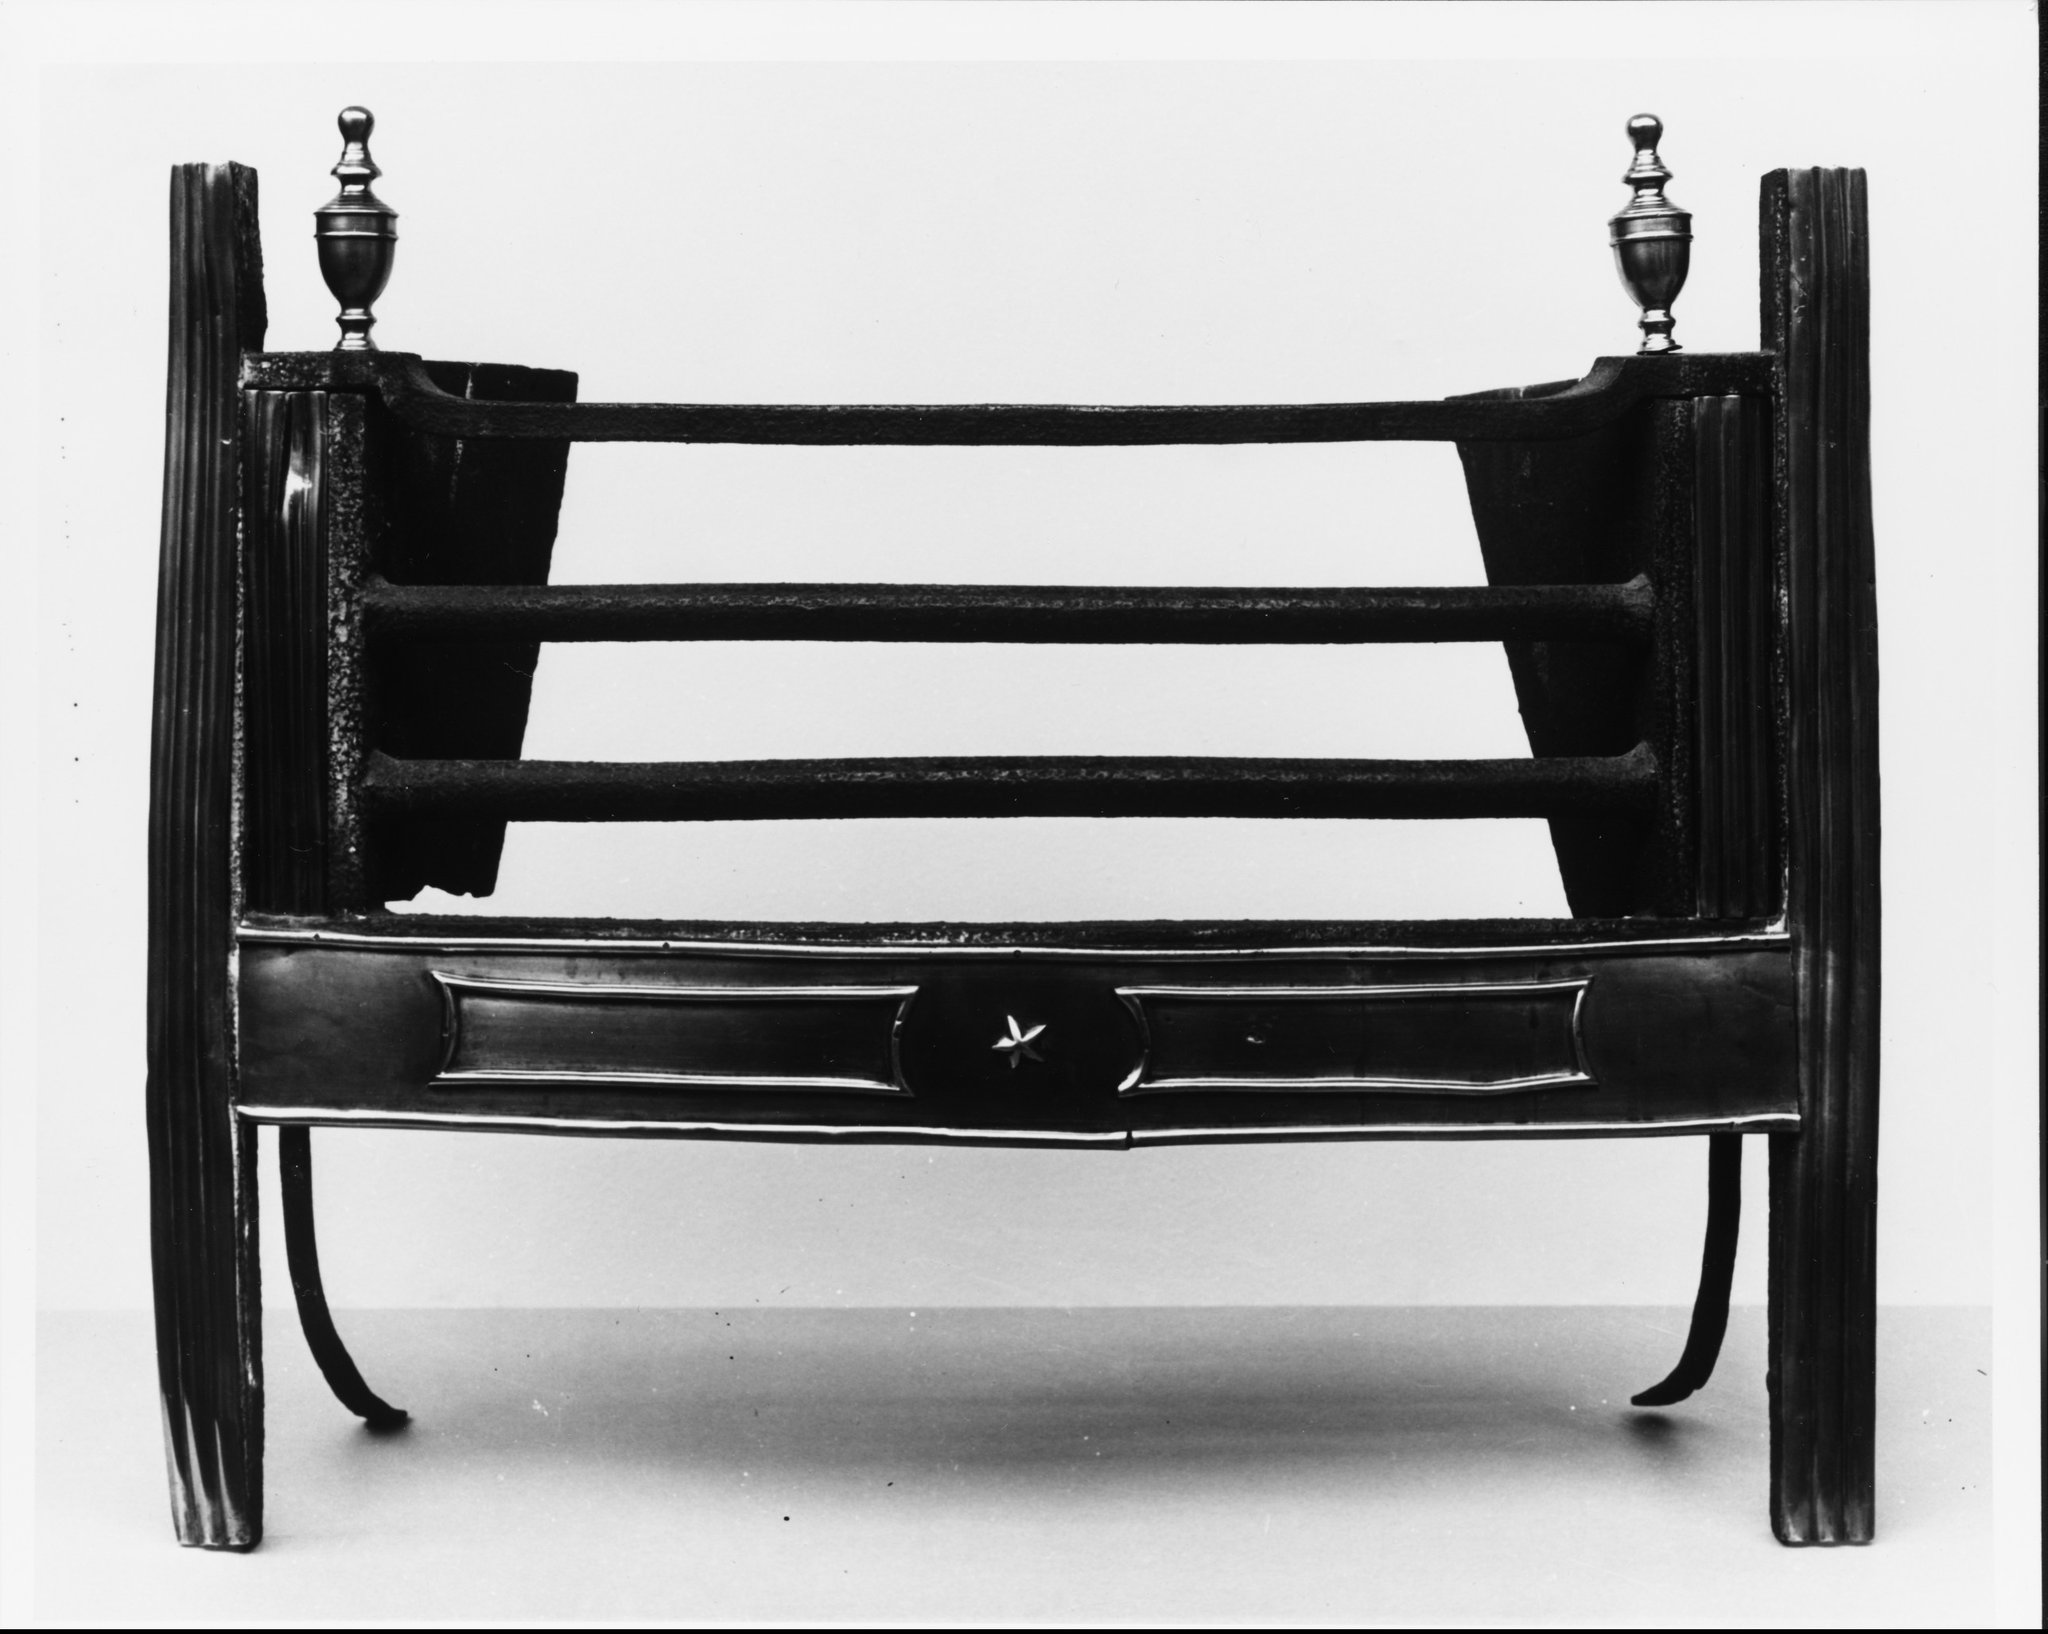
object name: fire grate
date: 1810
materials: brass, iron